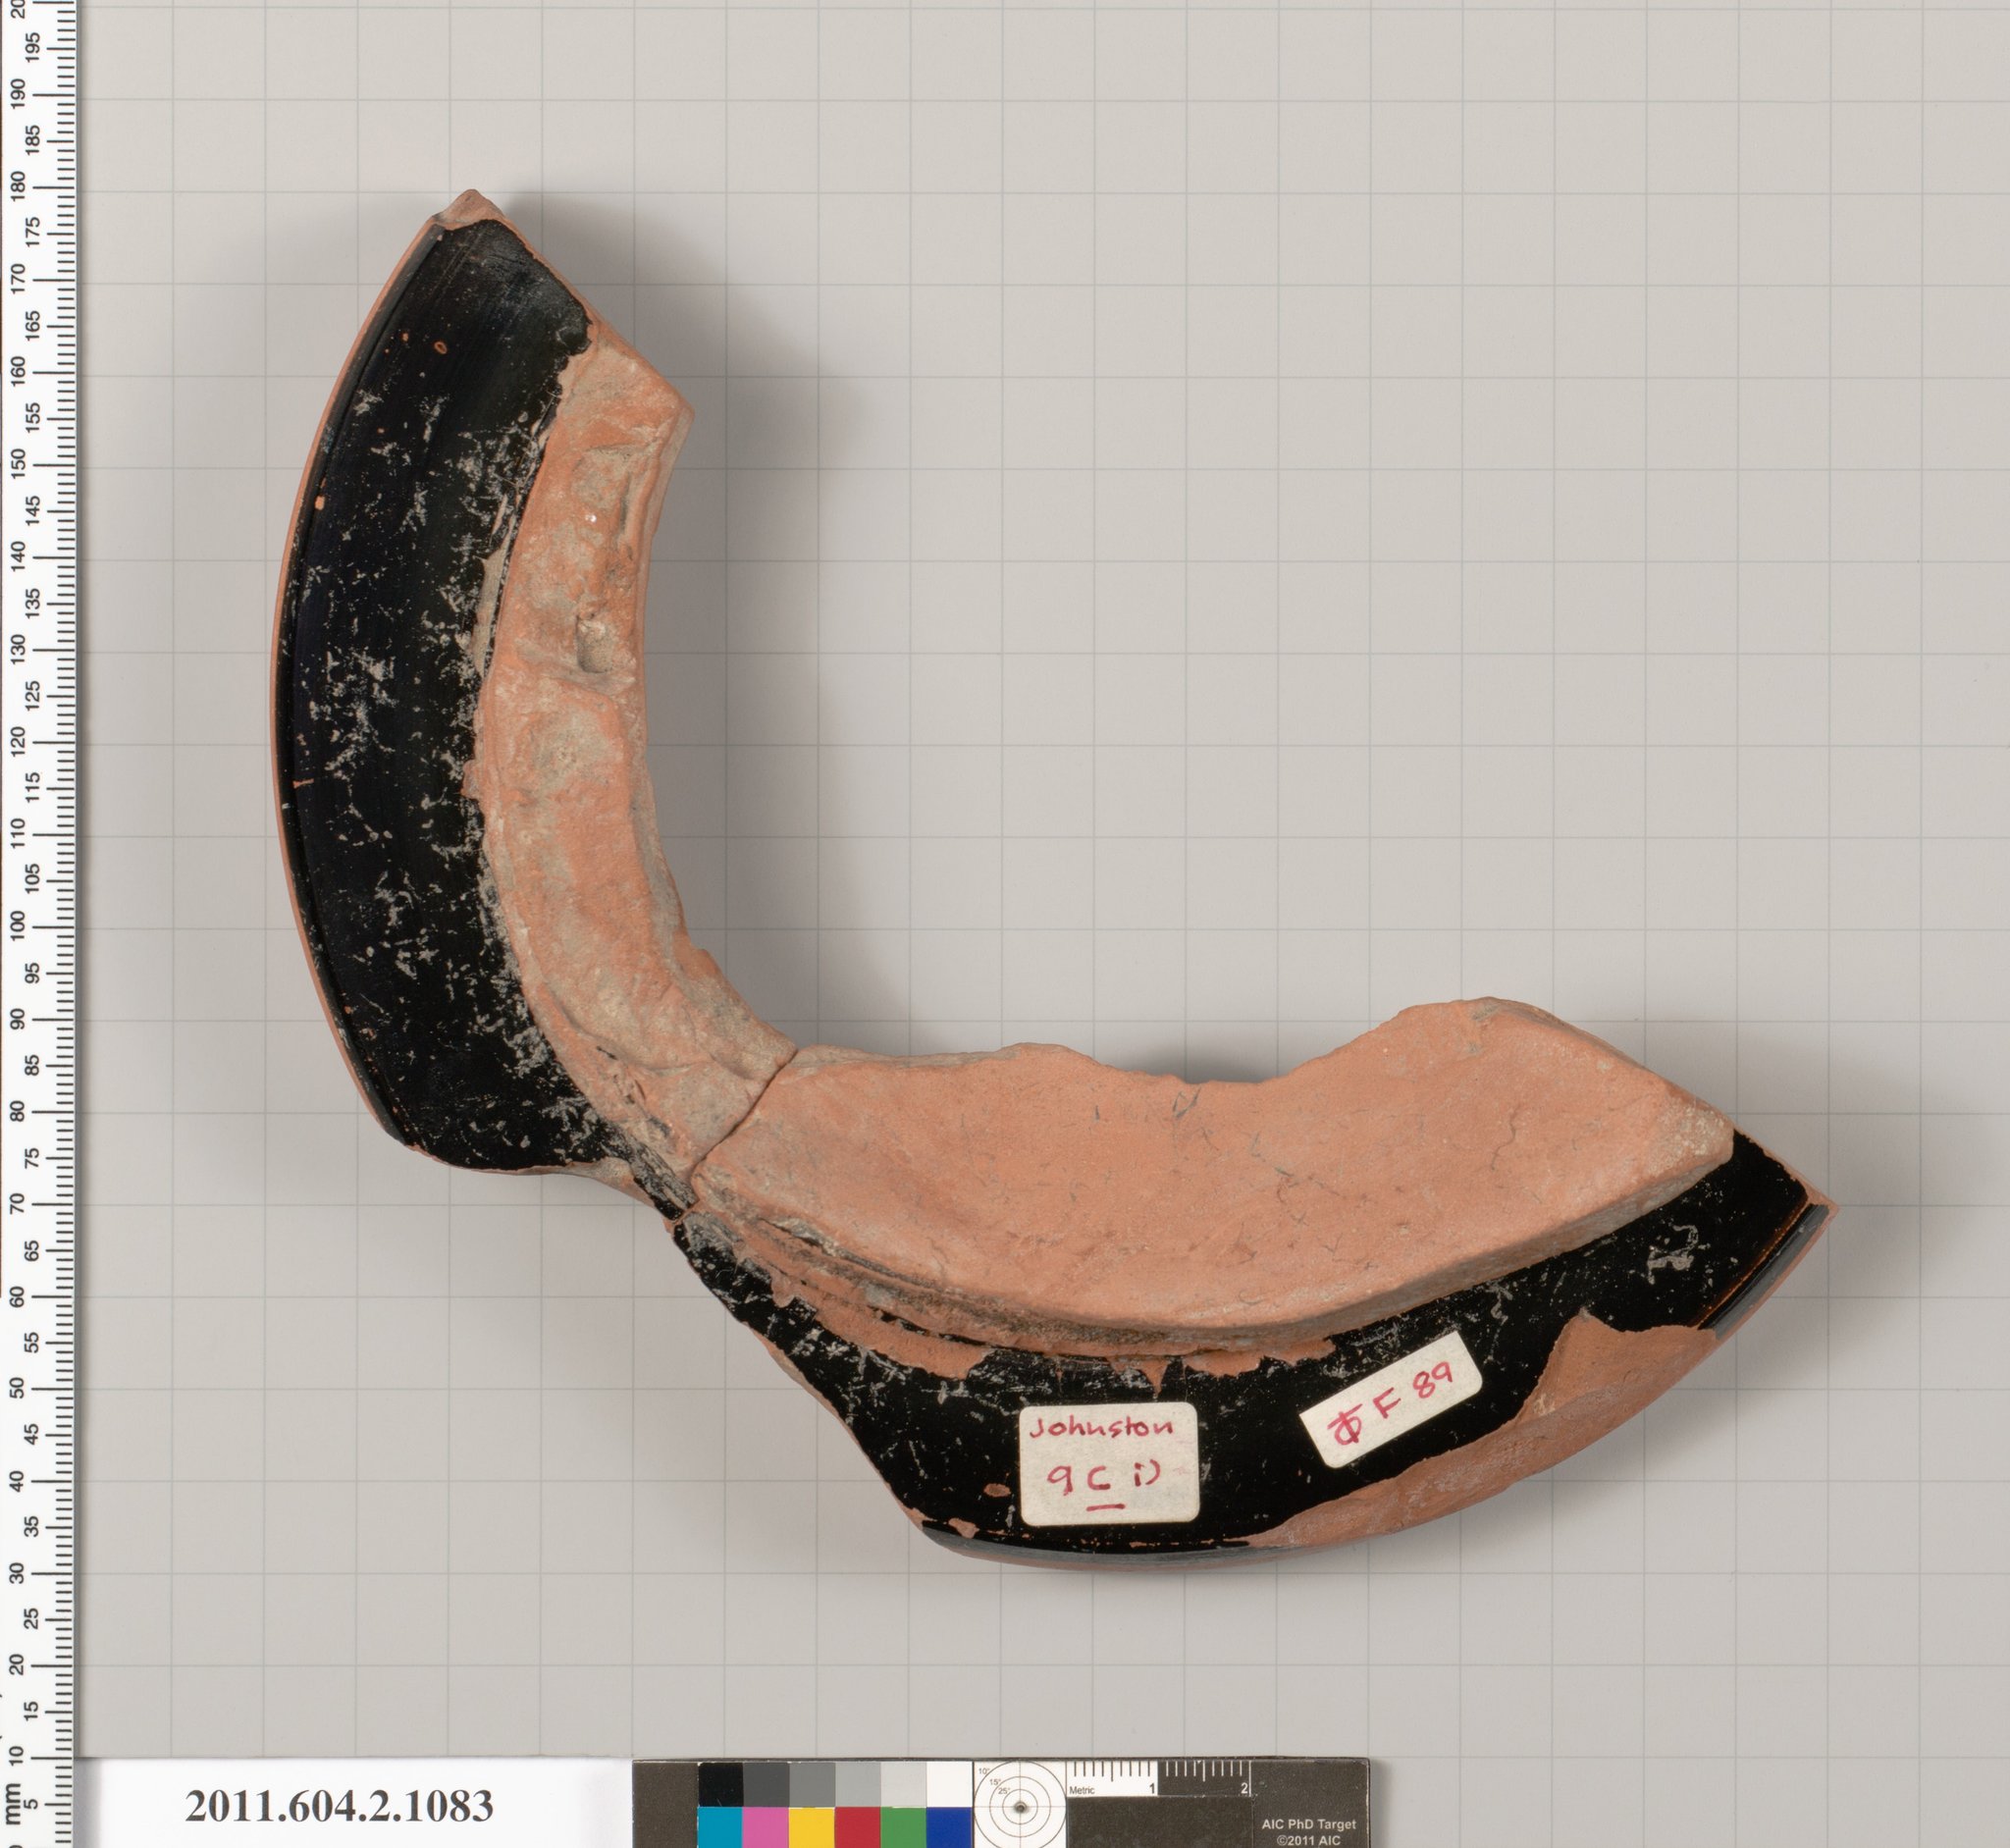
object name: hydria fragment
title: Terracotta fragment of a hydria (water jar)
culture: greek, attic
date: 534-501 BCE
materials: terracotta